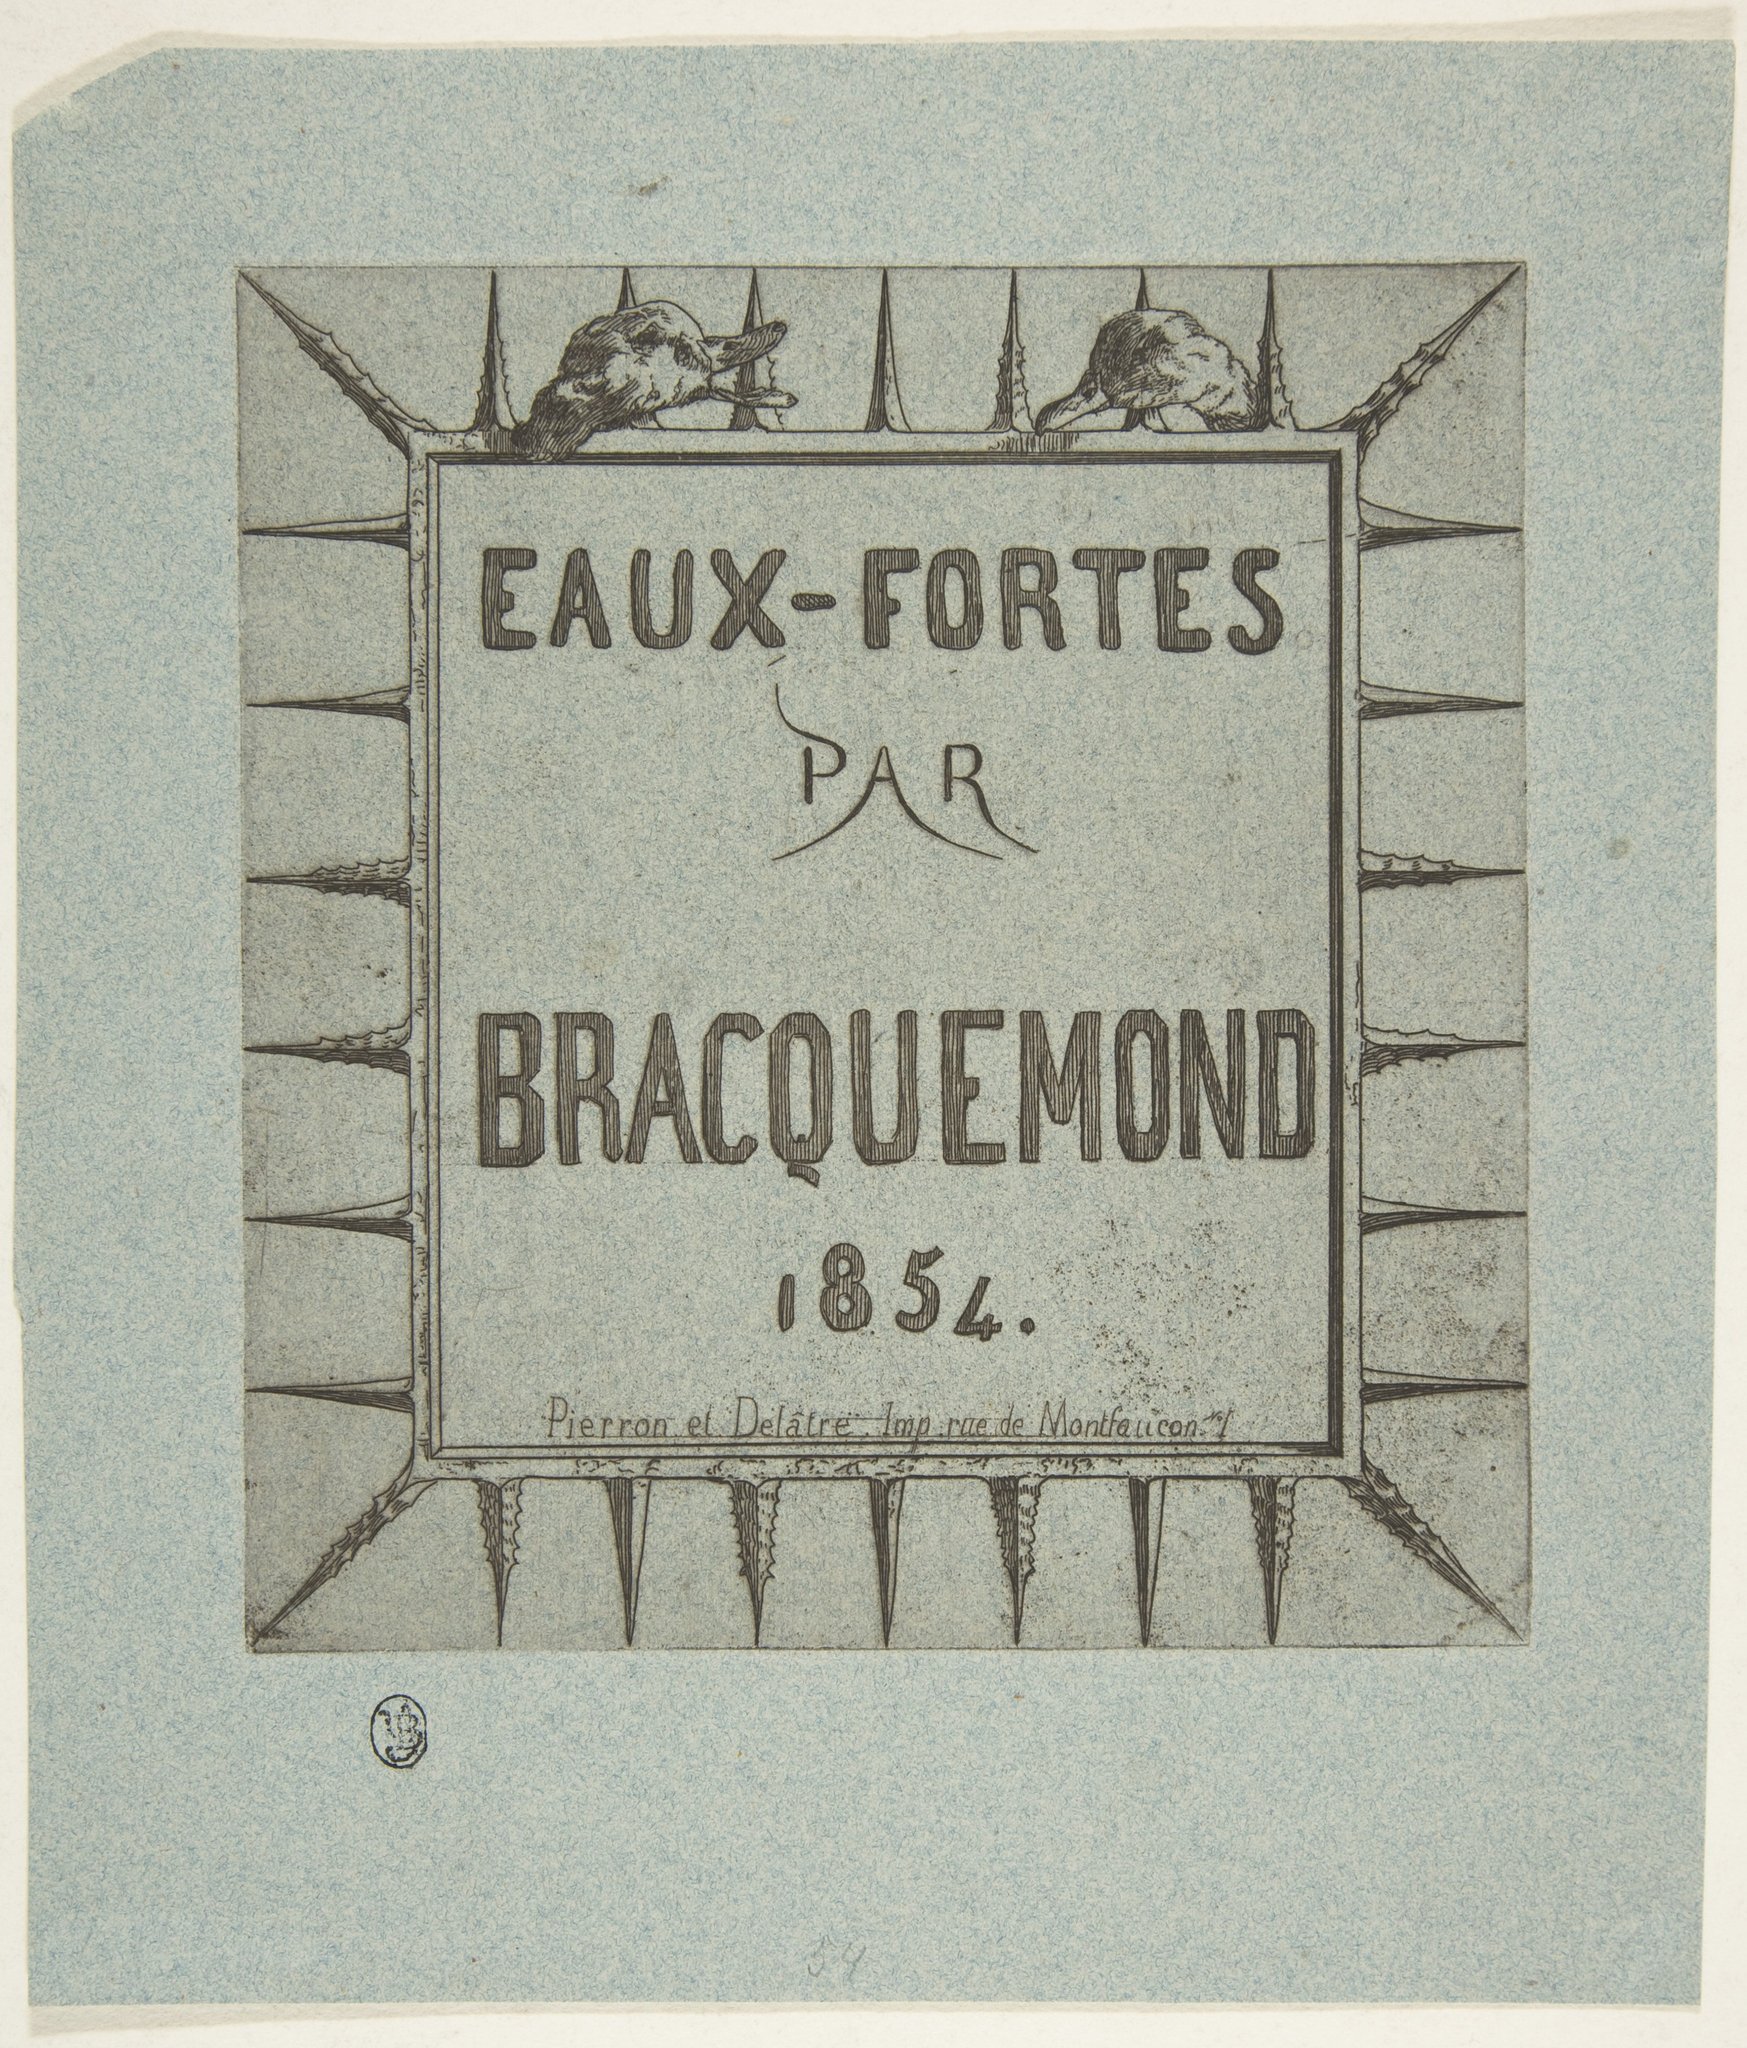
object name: print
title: Eaux-fortes par Bracquemond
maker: félix bracquemond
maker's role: artist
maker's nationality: french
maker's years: 1833-1914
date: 1854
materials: paper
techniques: etching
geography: france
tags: ducks